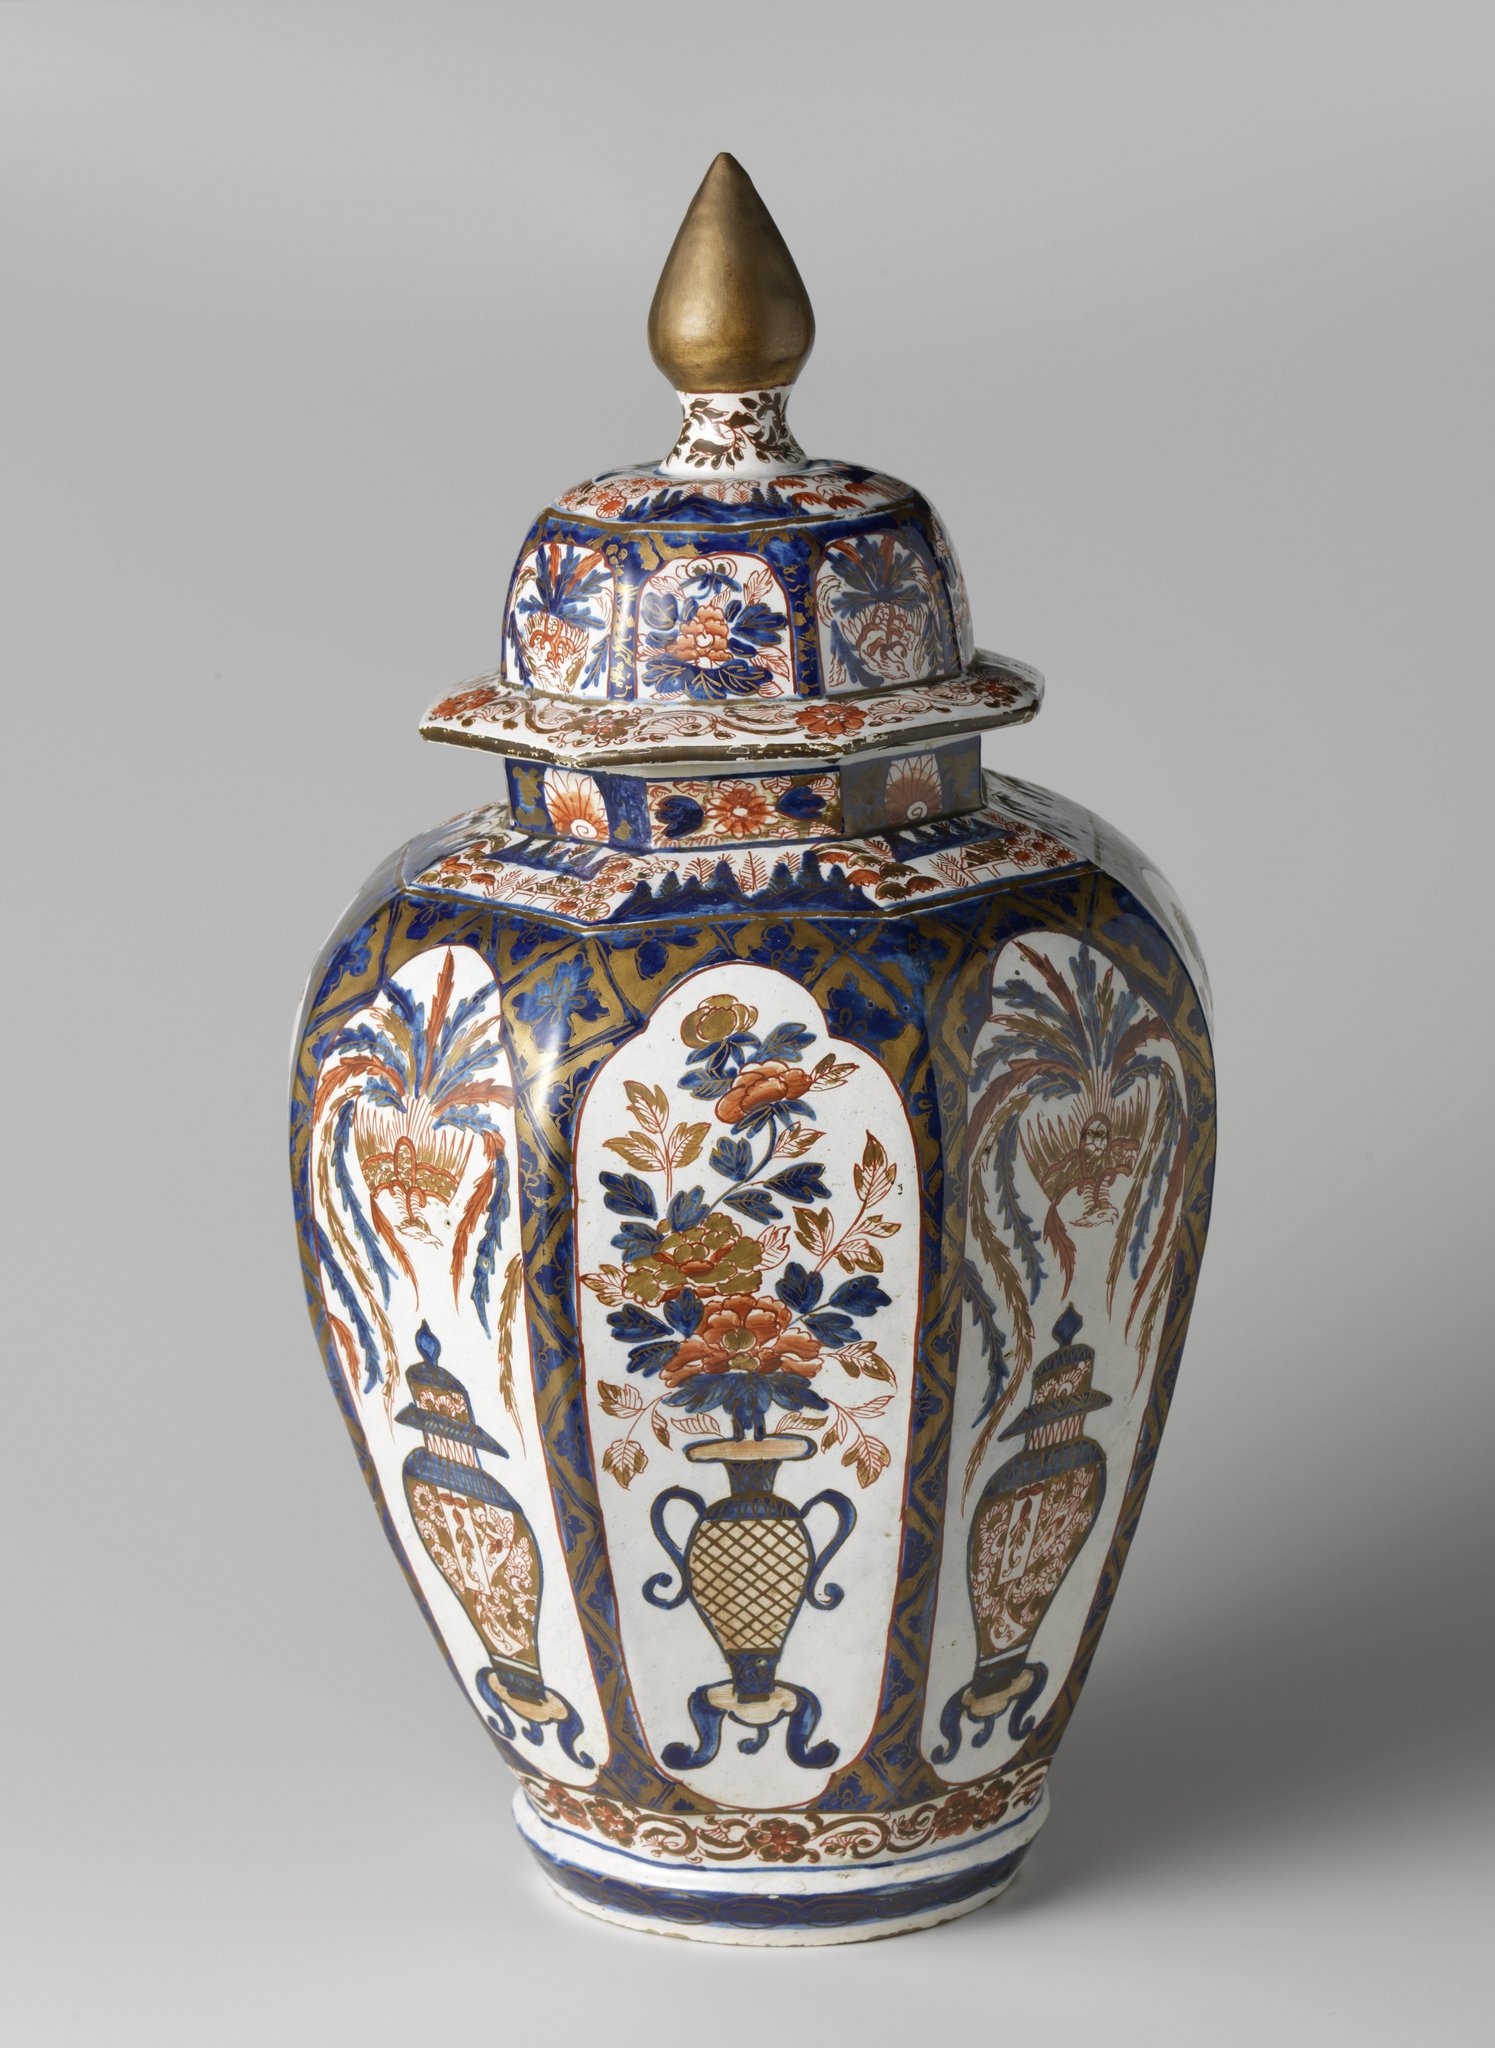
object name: covered jar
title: Pot, onderdeel van een kaststel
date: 1820-1850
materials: earthenware, glaze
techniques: painted, polychromy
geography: delft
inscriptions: collector's mark: ‘collection J.F. Loudon’, mark: ‘IVP & C’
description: Pot, van veelkleurig beschilderde faïence. De pot is achtkantig en op de acht kanten zijn acht vakken geschilderd. In vier vakken is een vaas met twee s-vormige handvatten, staand op een driepotig voetstuk en gevuld met bloemen geschilderd, in de andere vier vakken een pot met deksel op een driepotig voetstuk waarboven een feniks. De pot is onderdeel van een stel en is gemerkt.